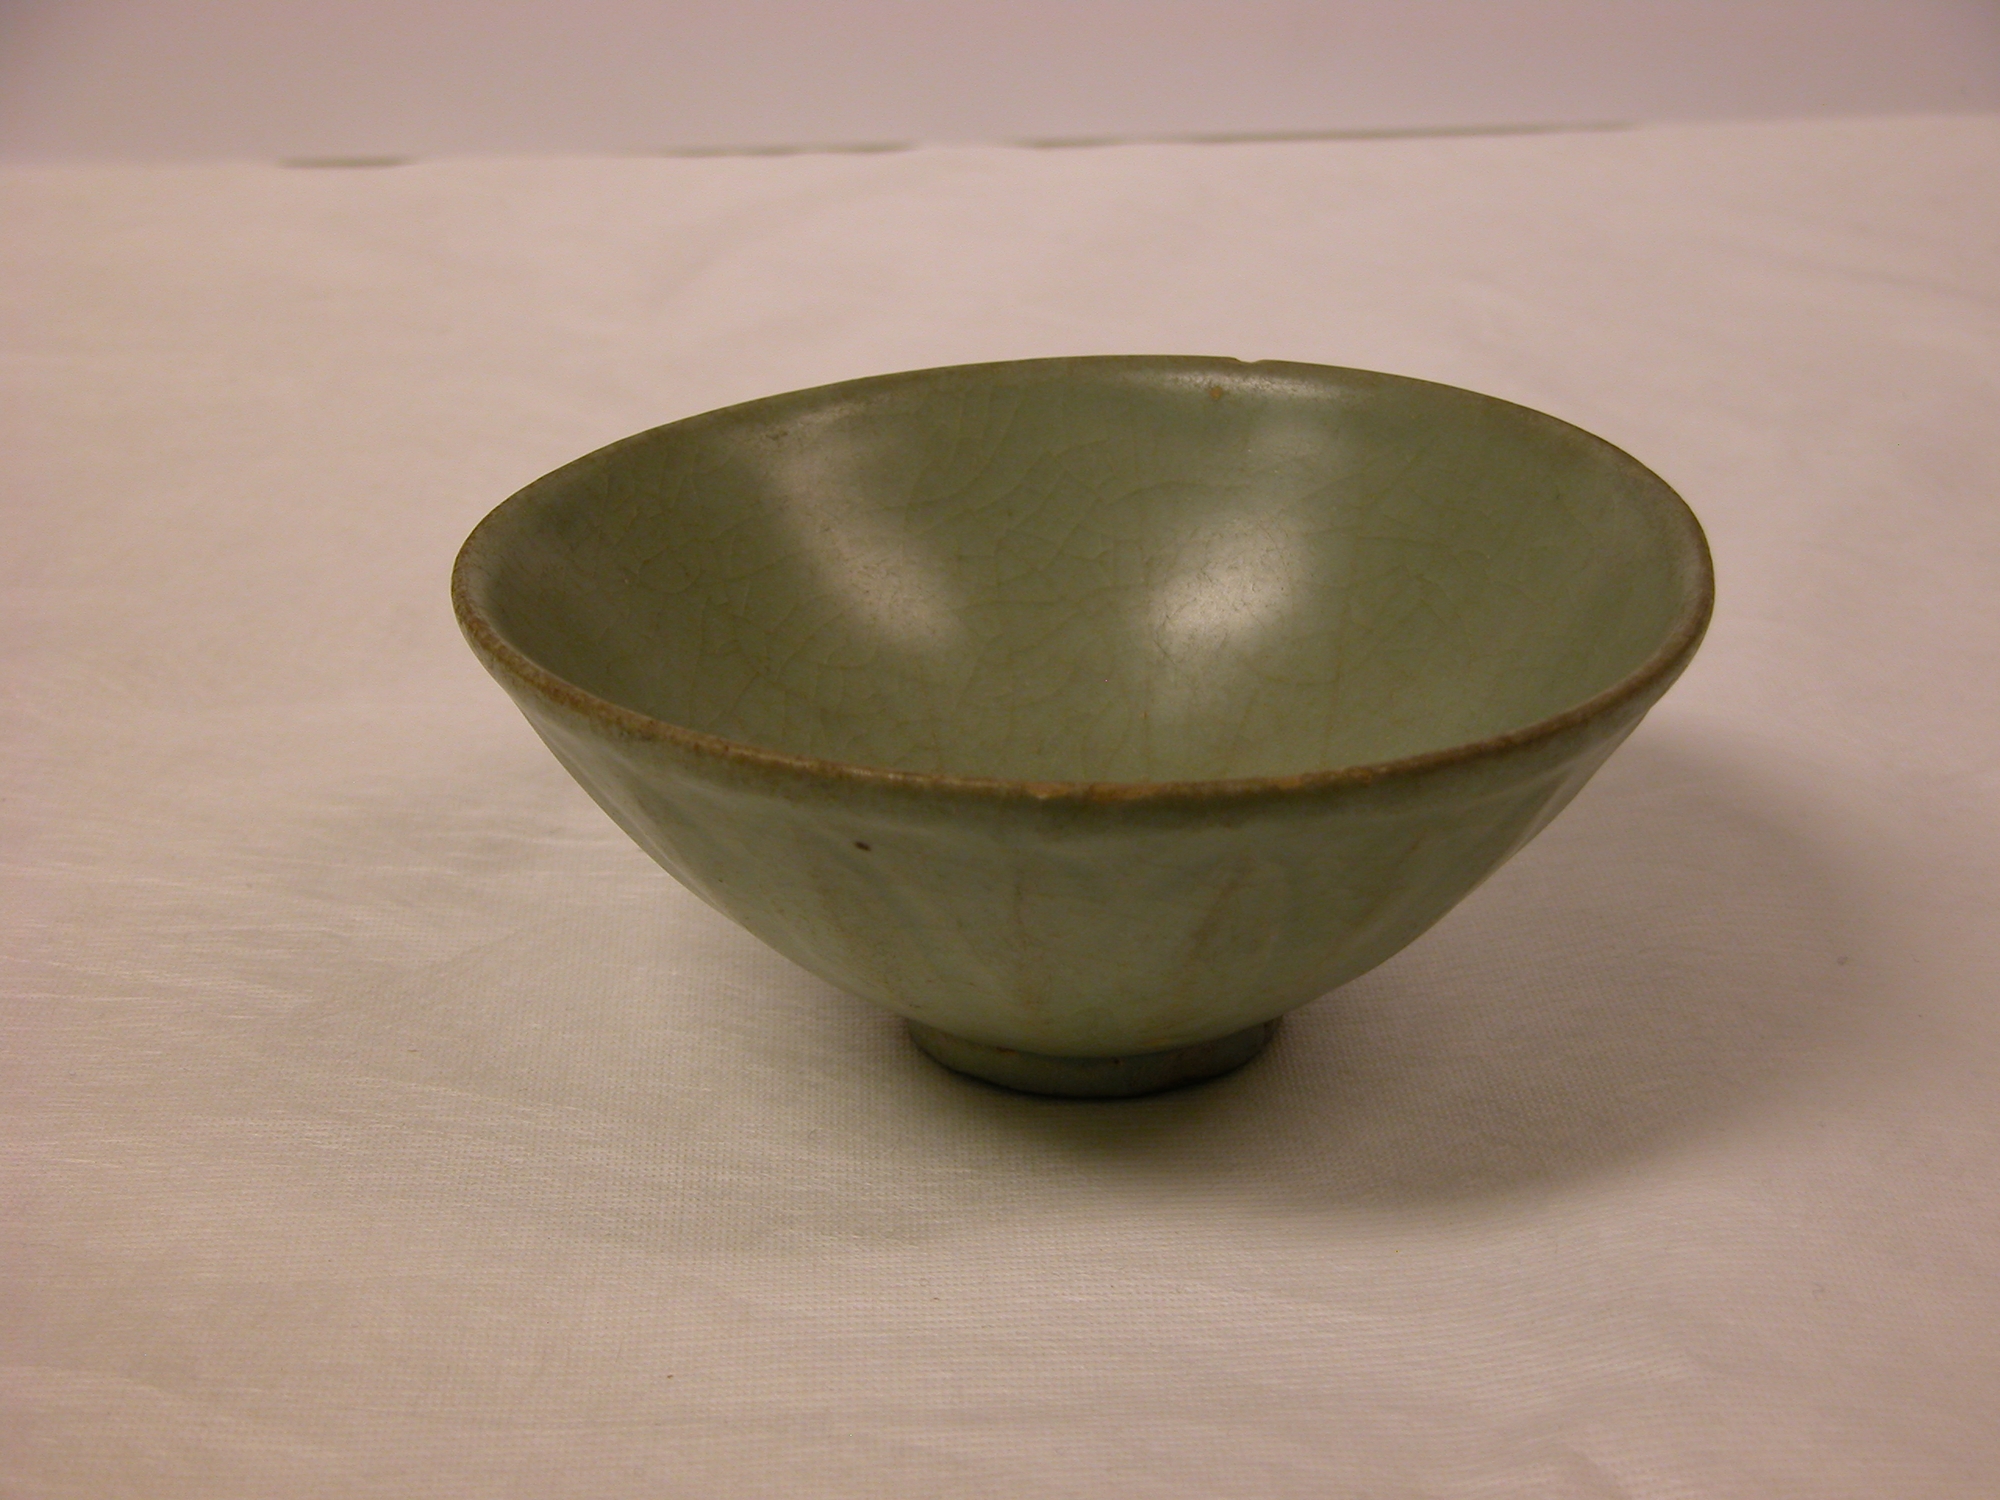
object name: bowl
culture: chinese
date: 1644-1911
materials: glaze, pottery